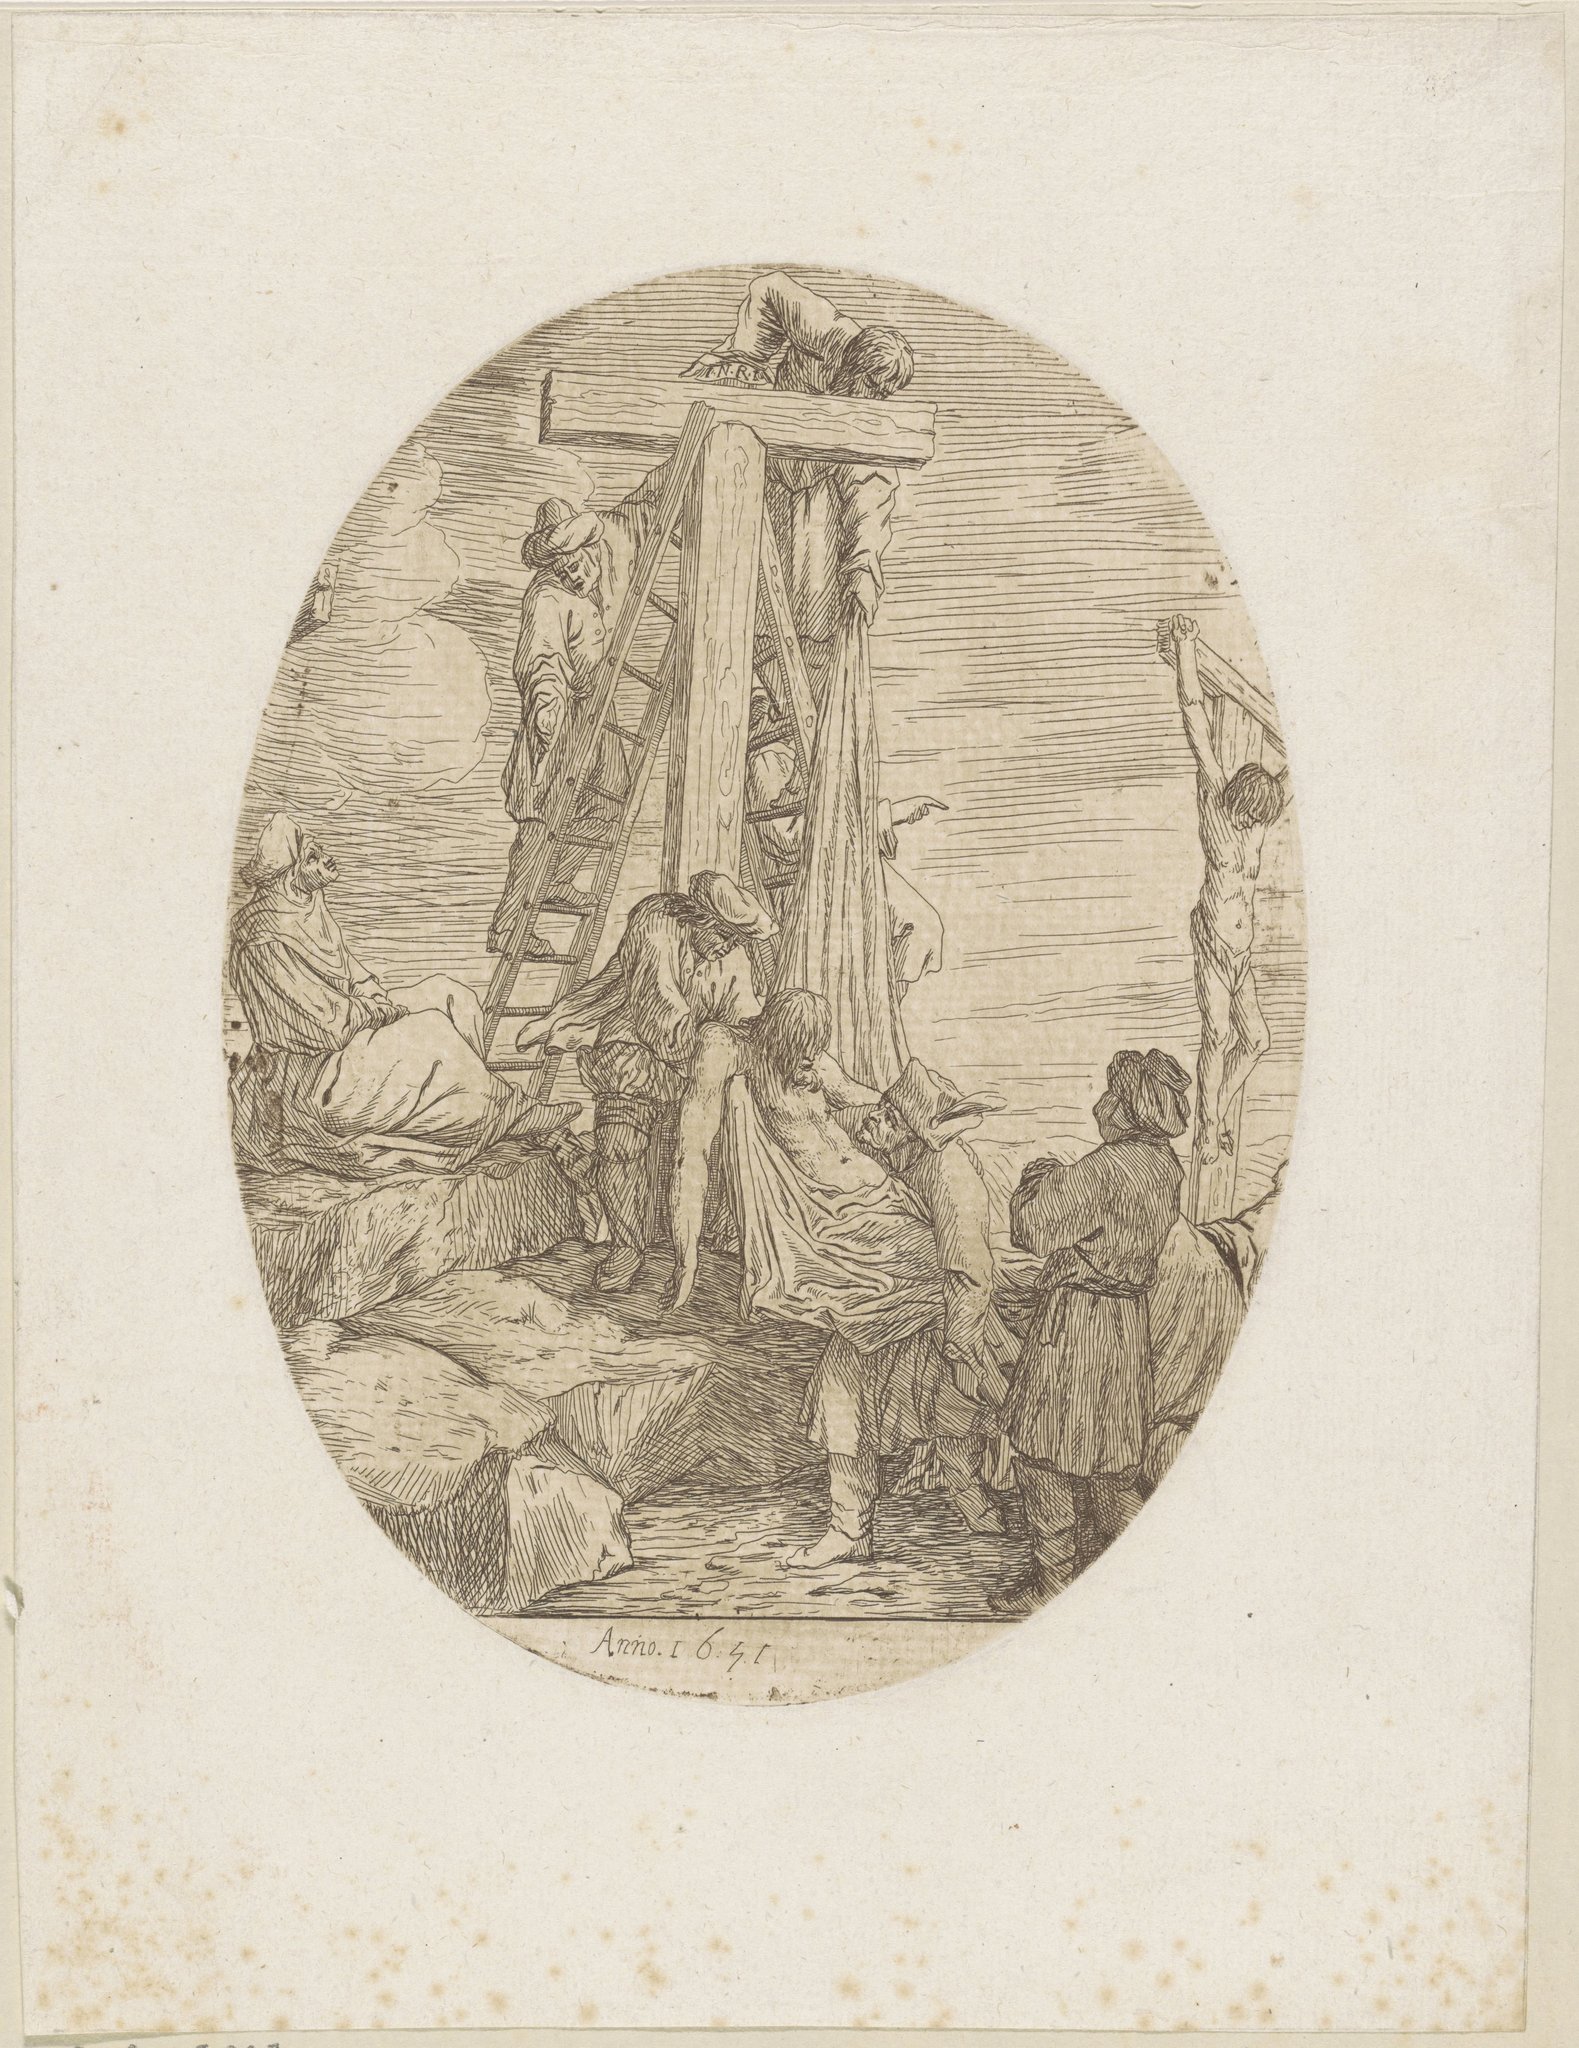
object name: print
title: Kruisafneming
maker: Anonymous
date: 1641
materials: paper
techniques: etching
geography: netherlands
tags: descent from the cross: christ is taken down from the cross, usually by nicodemus and joseph of arimathaea who are standing on the ladders (both arms of christ detached)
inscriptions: collector's mark: Lugt 240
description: Nikodemus en Josef van Arimatea halen de gestorven Christus van het kruis.